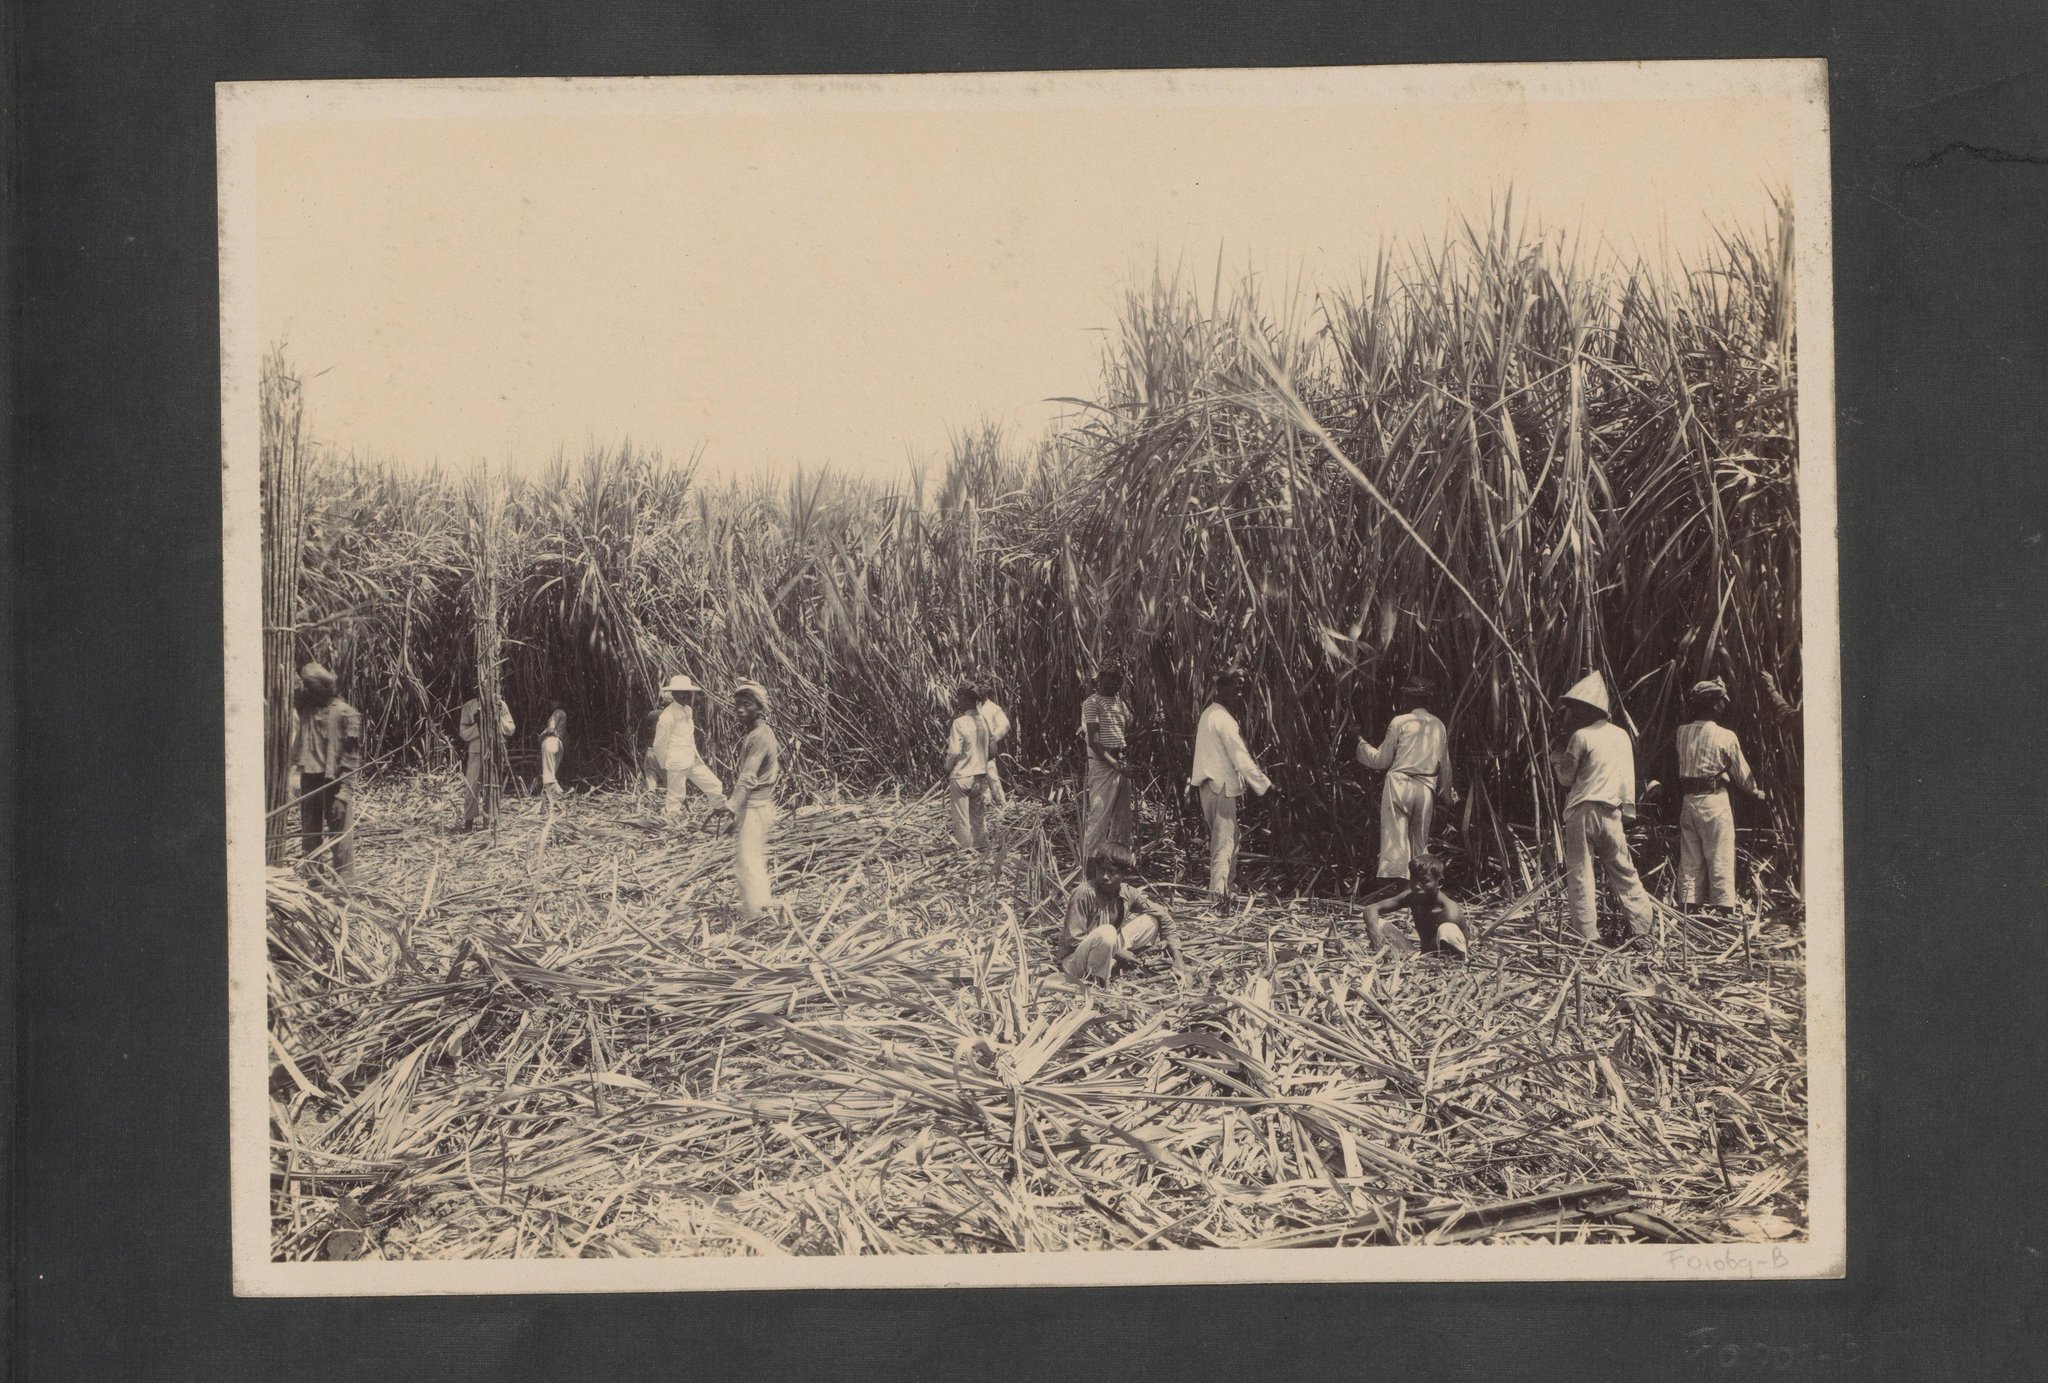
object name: photograph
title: Mannen werkzaam in de suikerrietoogst in Nederlands-Indië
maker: onnes kurkdjian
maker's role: fotograaf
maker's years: 1851-1903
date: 1912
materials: paper, photographic support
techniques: gelatin silver print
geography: dutch east indies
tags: plantation, farmers, dutch east indies, the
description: Onderdeel van Reisalbum met veertig foto's van Nederlands-Indië.